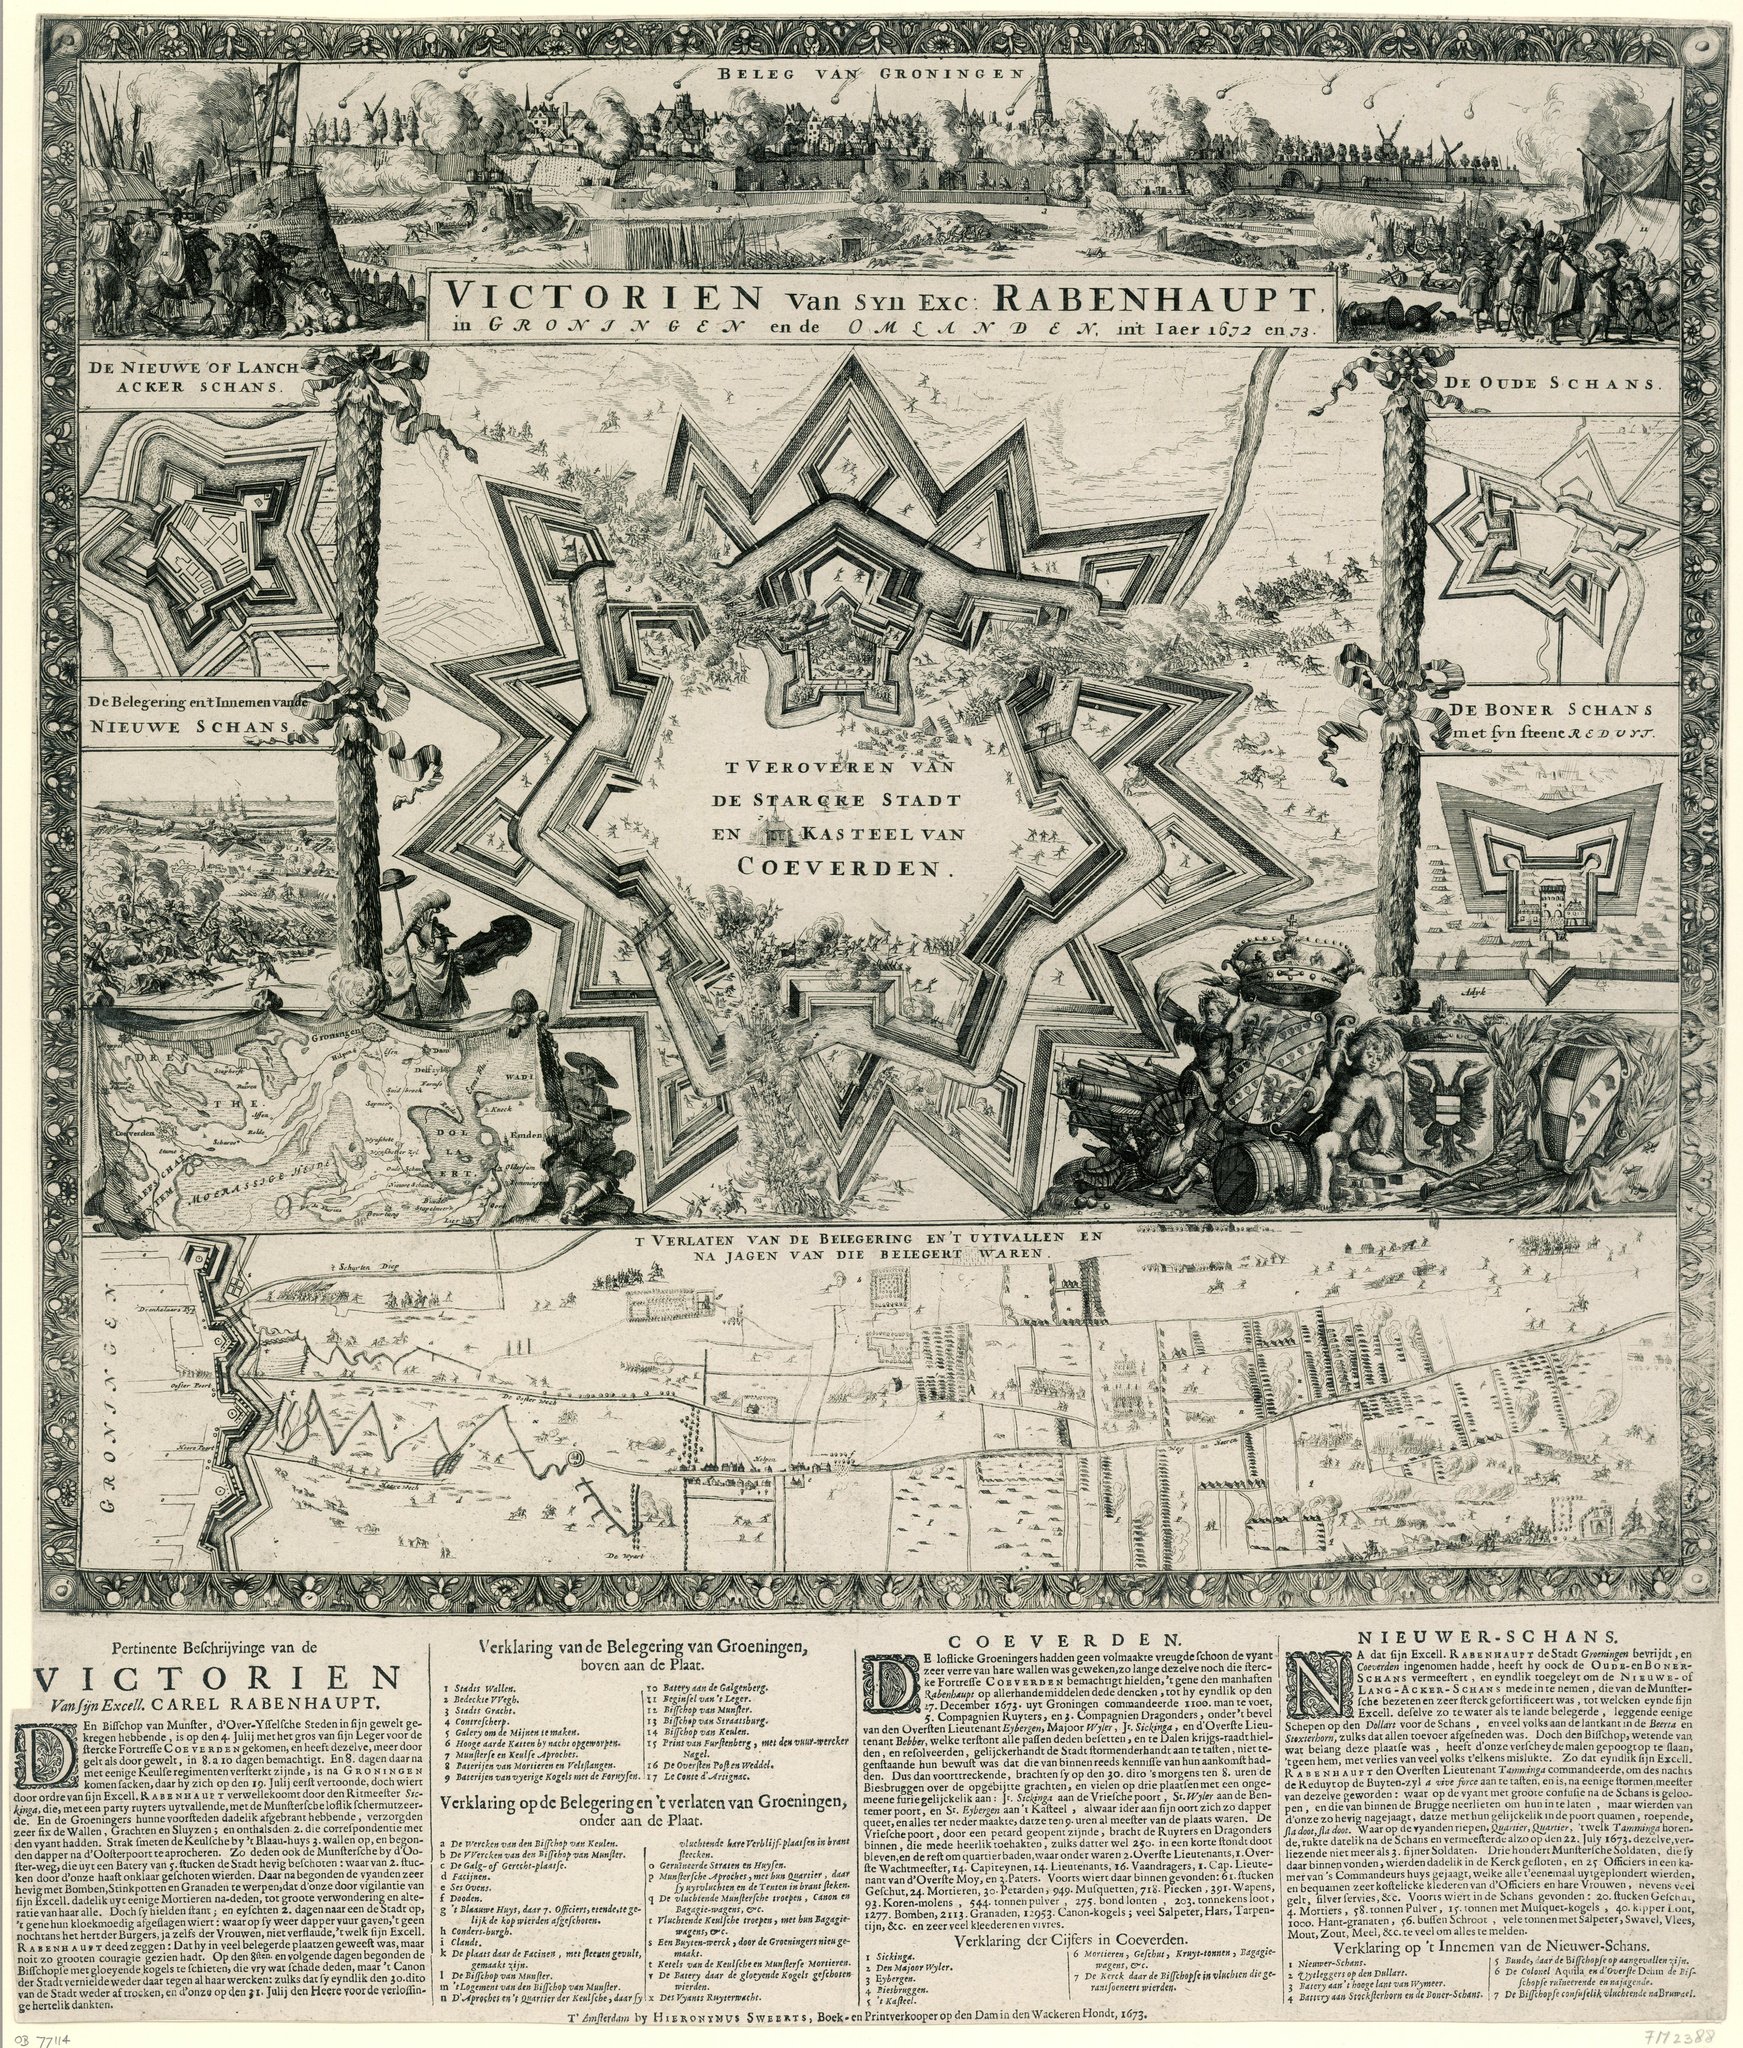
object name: print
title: Victorien van syn exc. Rabenhaupt, in Groningen en de Omlanden, int iaer 1672 en 73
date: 1673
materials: paper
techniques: engraving, etching, letterpress printing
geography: amsterdam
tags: coat of arms (as symbol of the state, etc.), siege, position war, capture of city (after the siege), fortifications, military engineering, maps of cities, groningen (province), rampjaar (disaster year)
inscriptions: date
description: Groot blad met voorstellingen en beschrijvingen van het beleg van Groningen en de verovering van Coevorden en andere overwinningen van de Duitse veldheer, in Nederlandse dienst, Karl Rabenhaupt, baron von Sucha, in de jaren 1672-1673. Centraal staat het beleg van Coevorden, boven het beleg van Groningen. Links de verovering van de Nieuwe Schans en rechts de veroveringen van de Oude Schans en de Boner Schans. Onderaan een voorstelling van het verjagen van de belegeraars van Groningen. Rechts daarboven putti met het wapen van de provincie Groningen, de stad Groningen en nog een wapen. Onder de voorstelling teksten over vier kolommen met beschrijvingen van de gebeurtenissen.